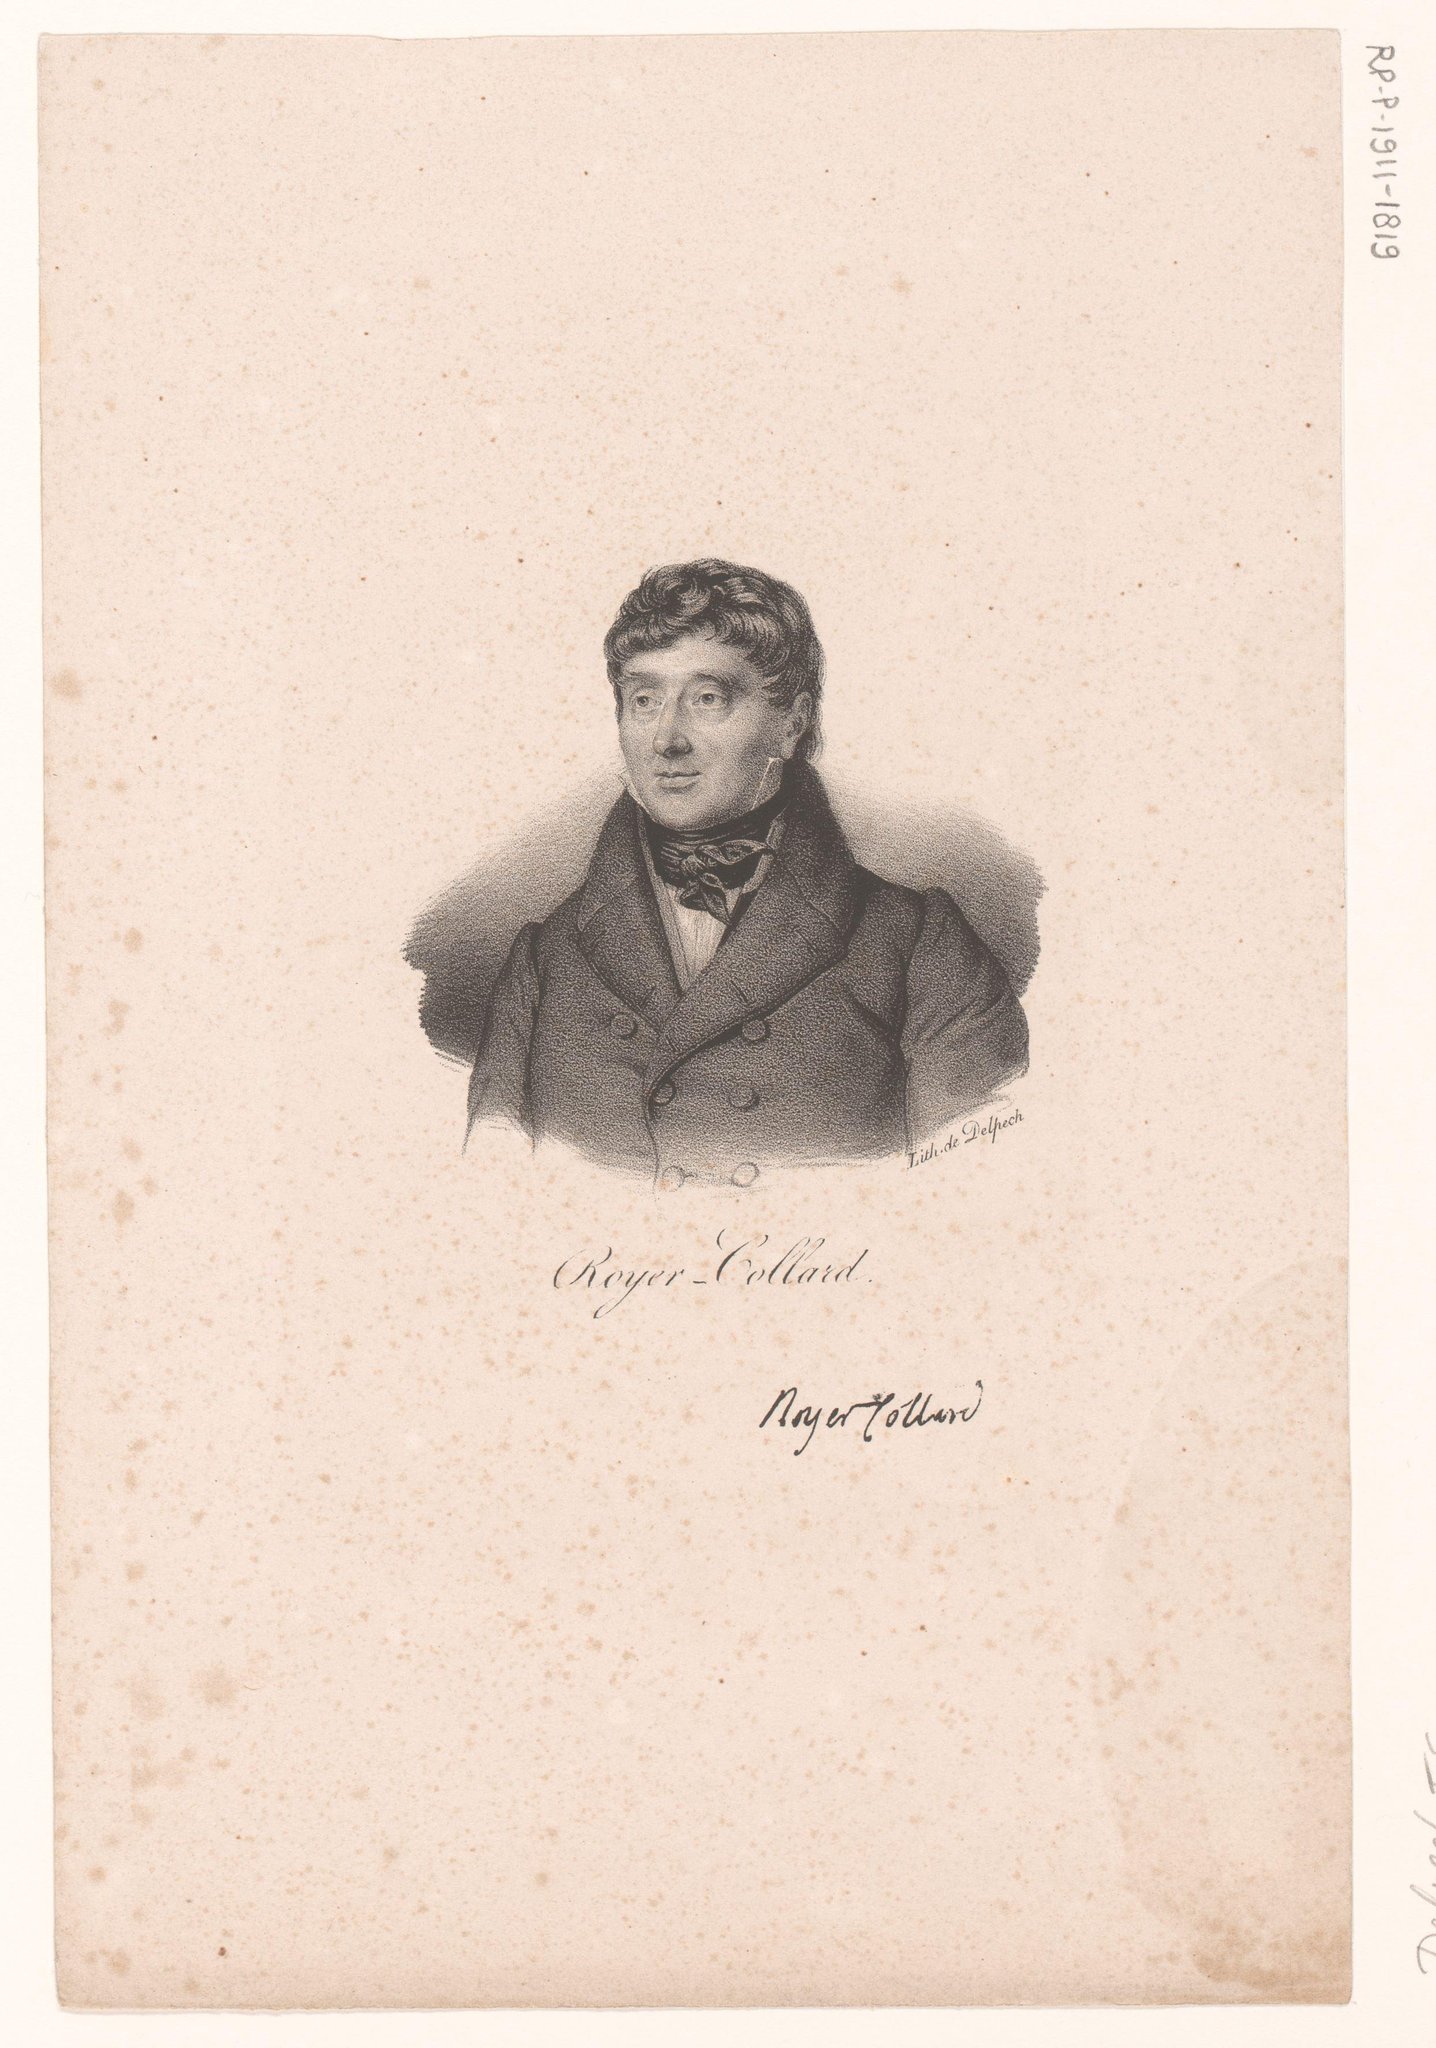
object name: print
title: Portret van Pierre-Paul Royer-Collard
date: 1818-1842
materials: paper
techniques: lithograph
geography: paris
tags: politician, historical persons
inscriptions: collector's mark: Lugt 2228a